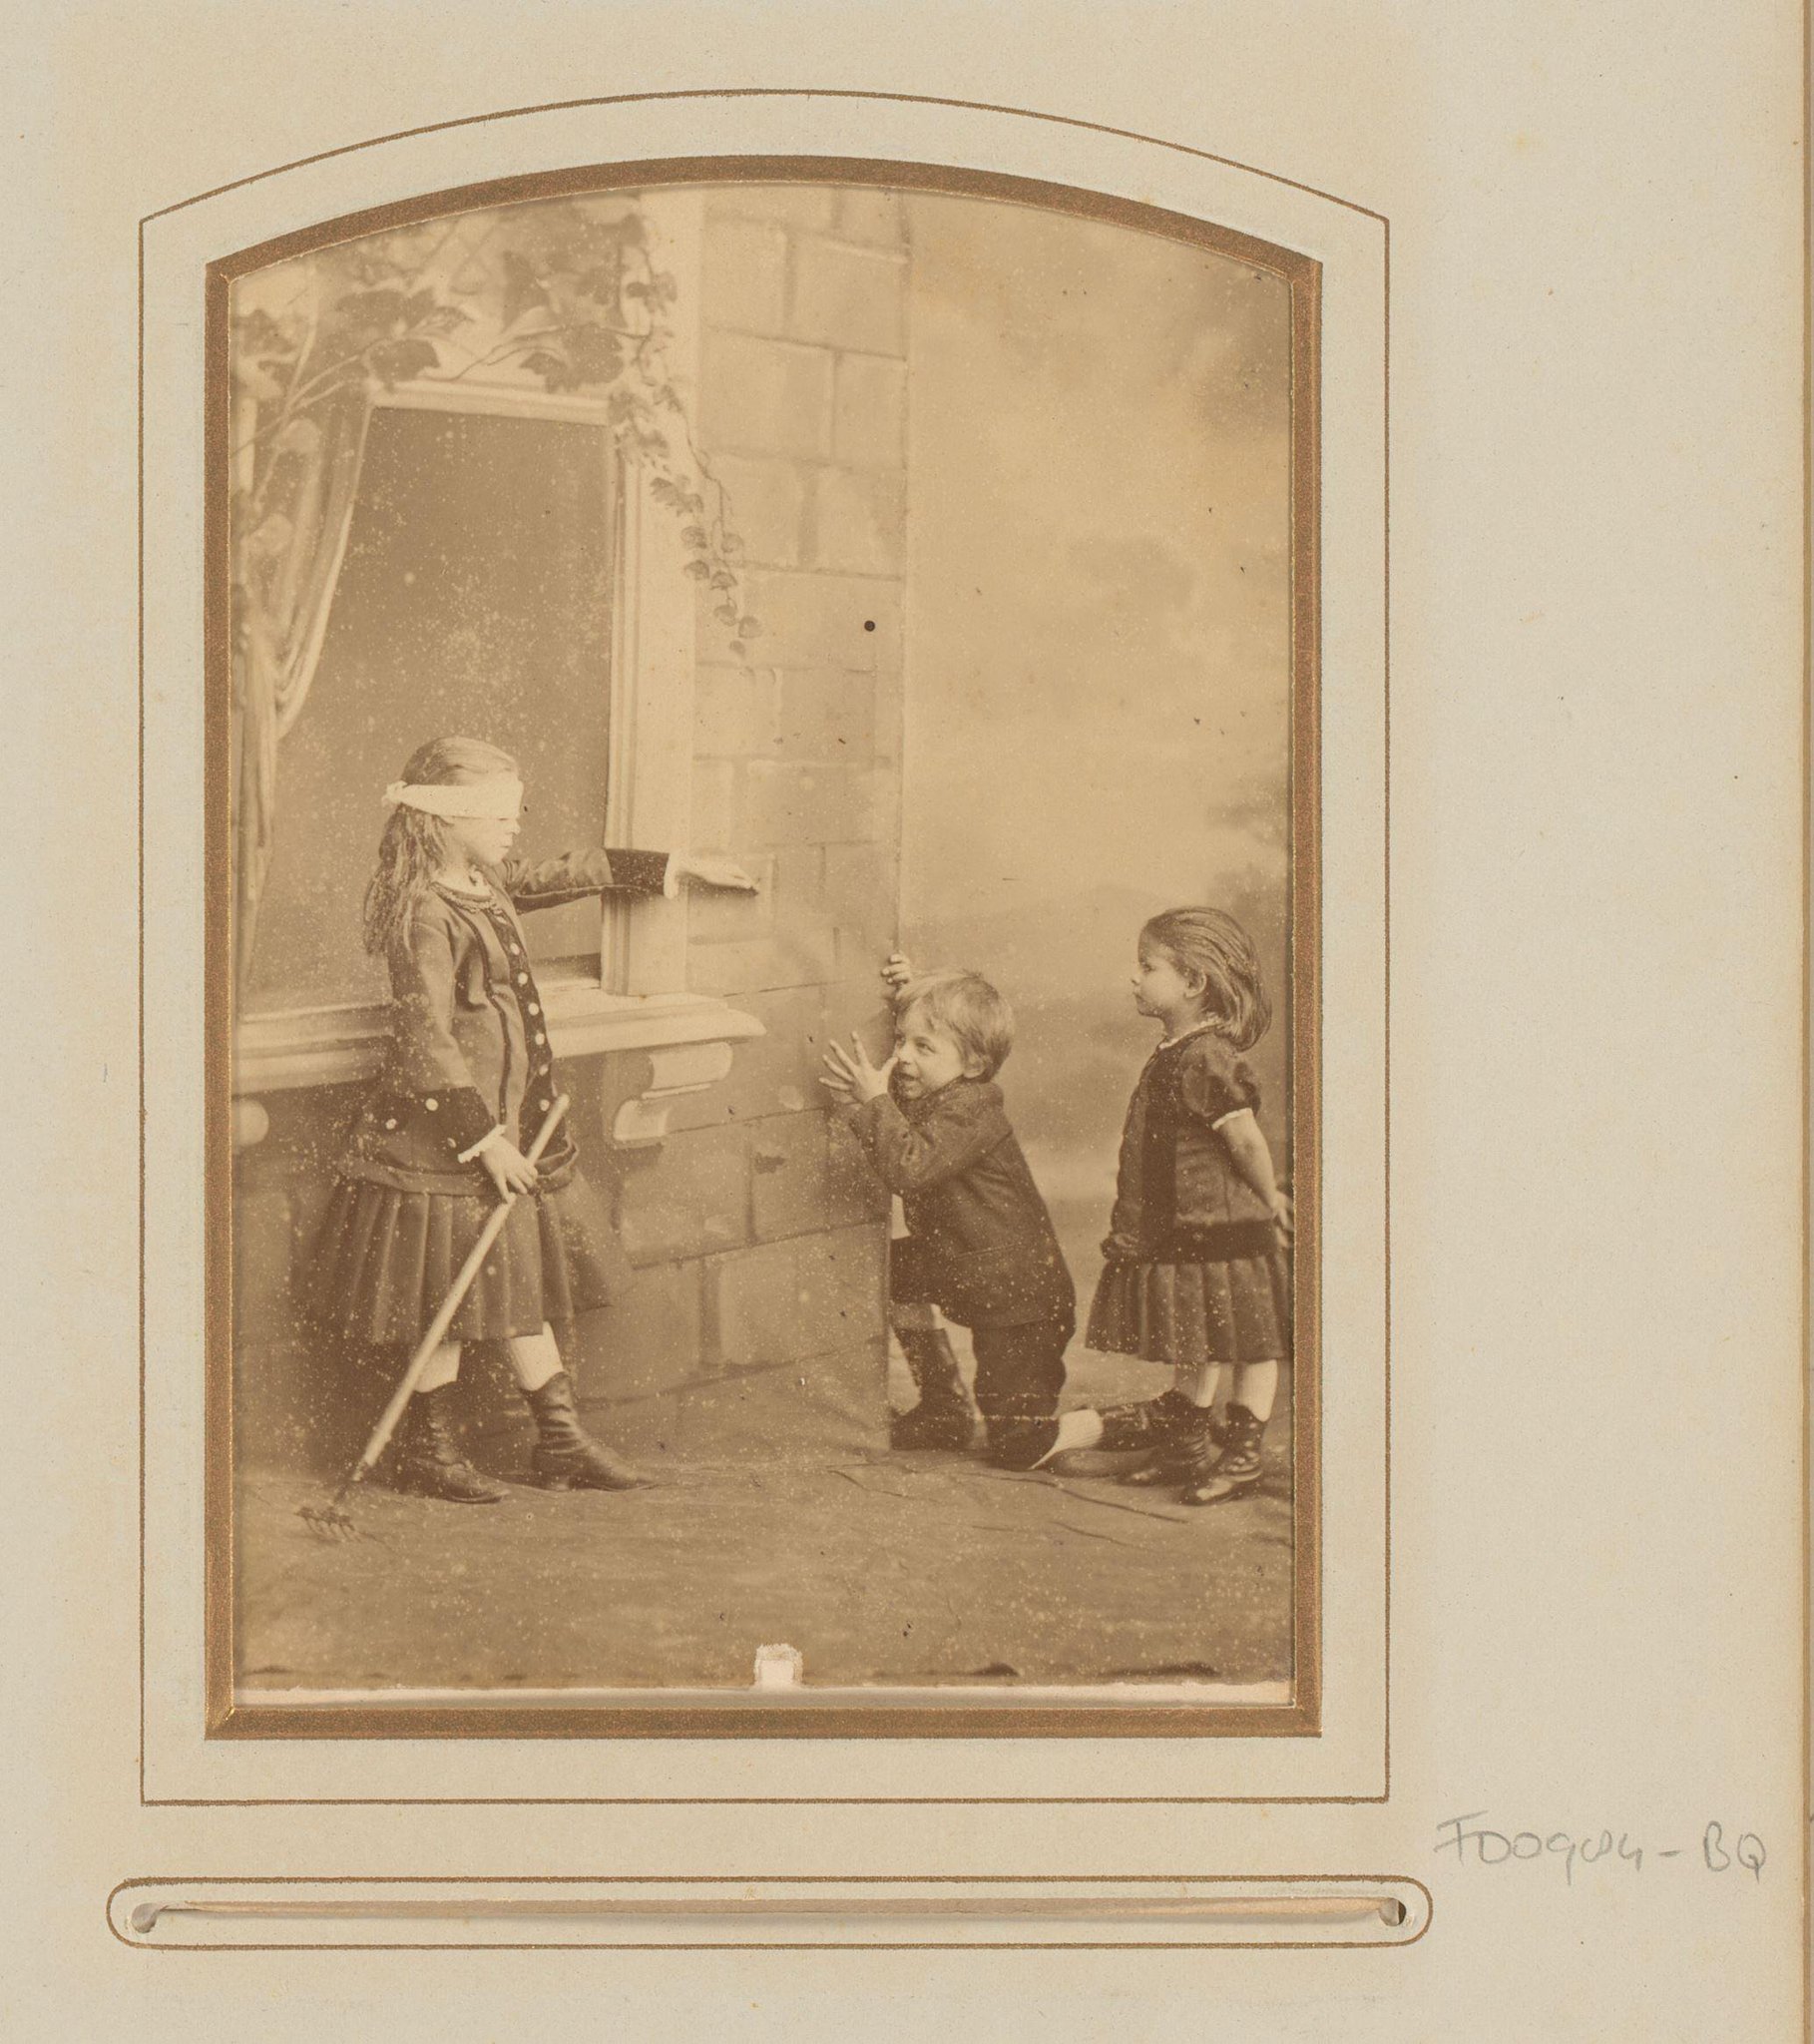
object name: cabinet photograph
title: Hier bin ich! Me voilà!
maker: e. linde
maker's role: publisher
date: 1883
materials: cardboard, photographic support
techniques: albumen print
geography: berlin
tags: hide-and-seek, child (+ three persons)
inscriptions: number: ‘No. 130.’